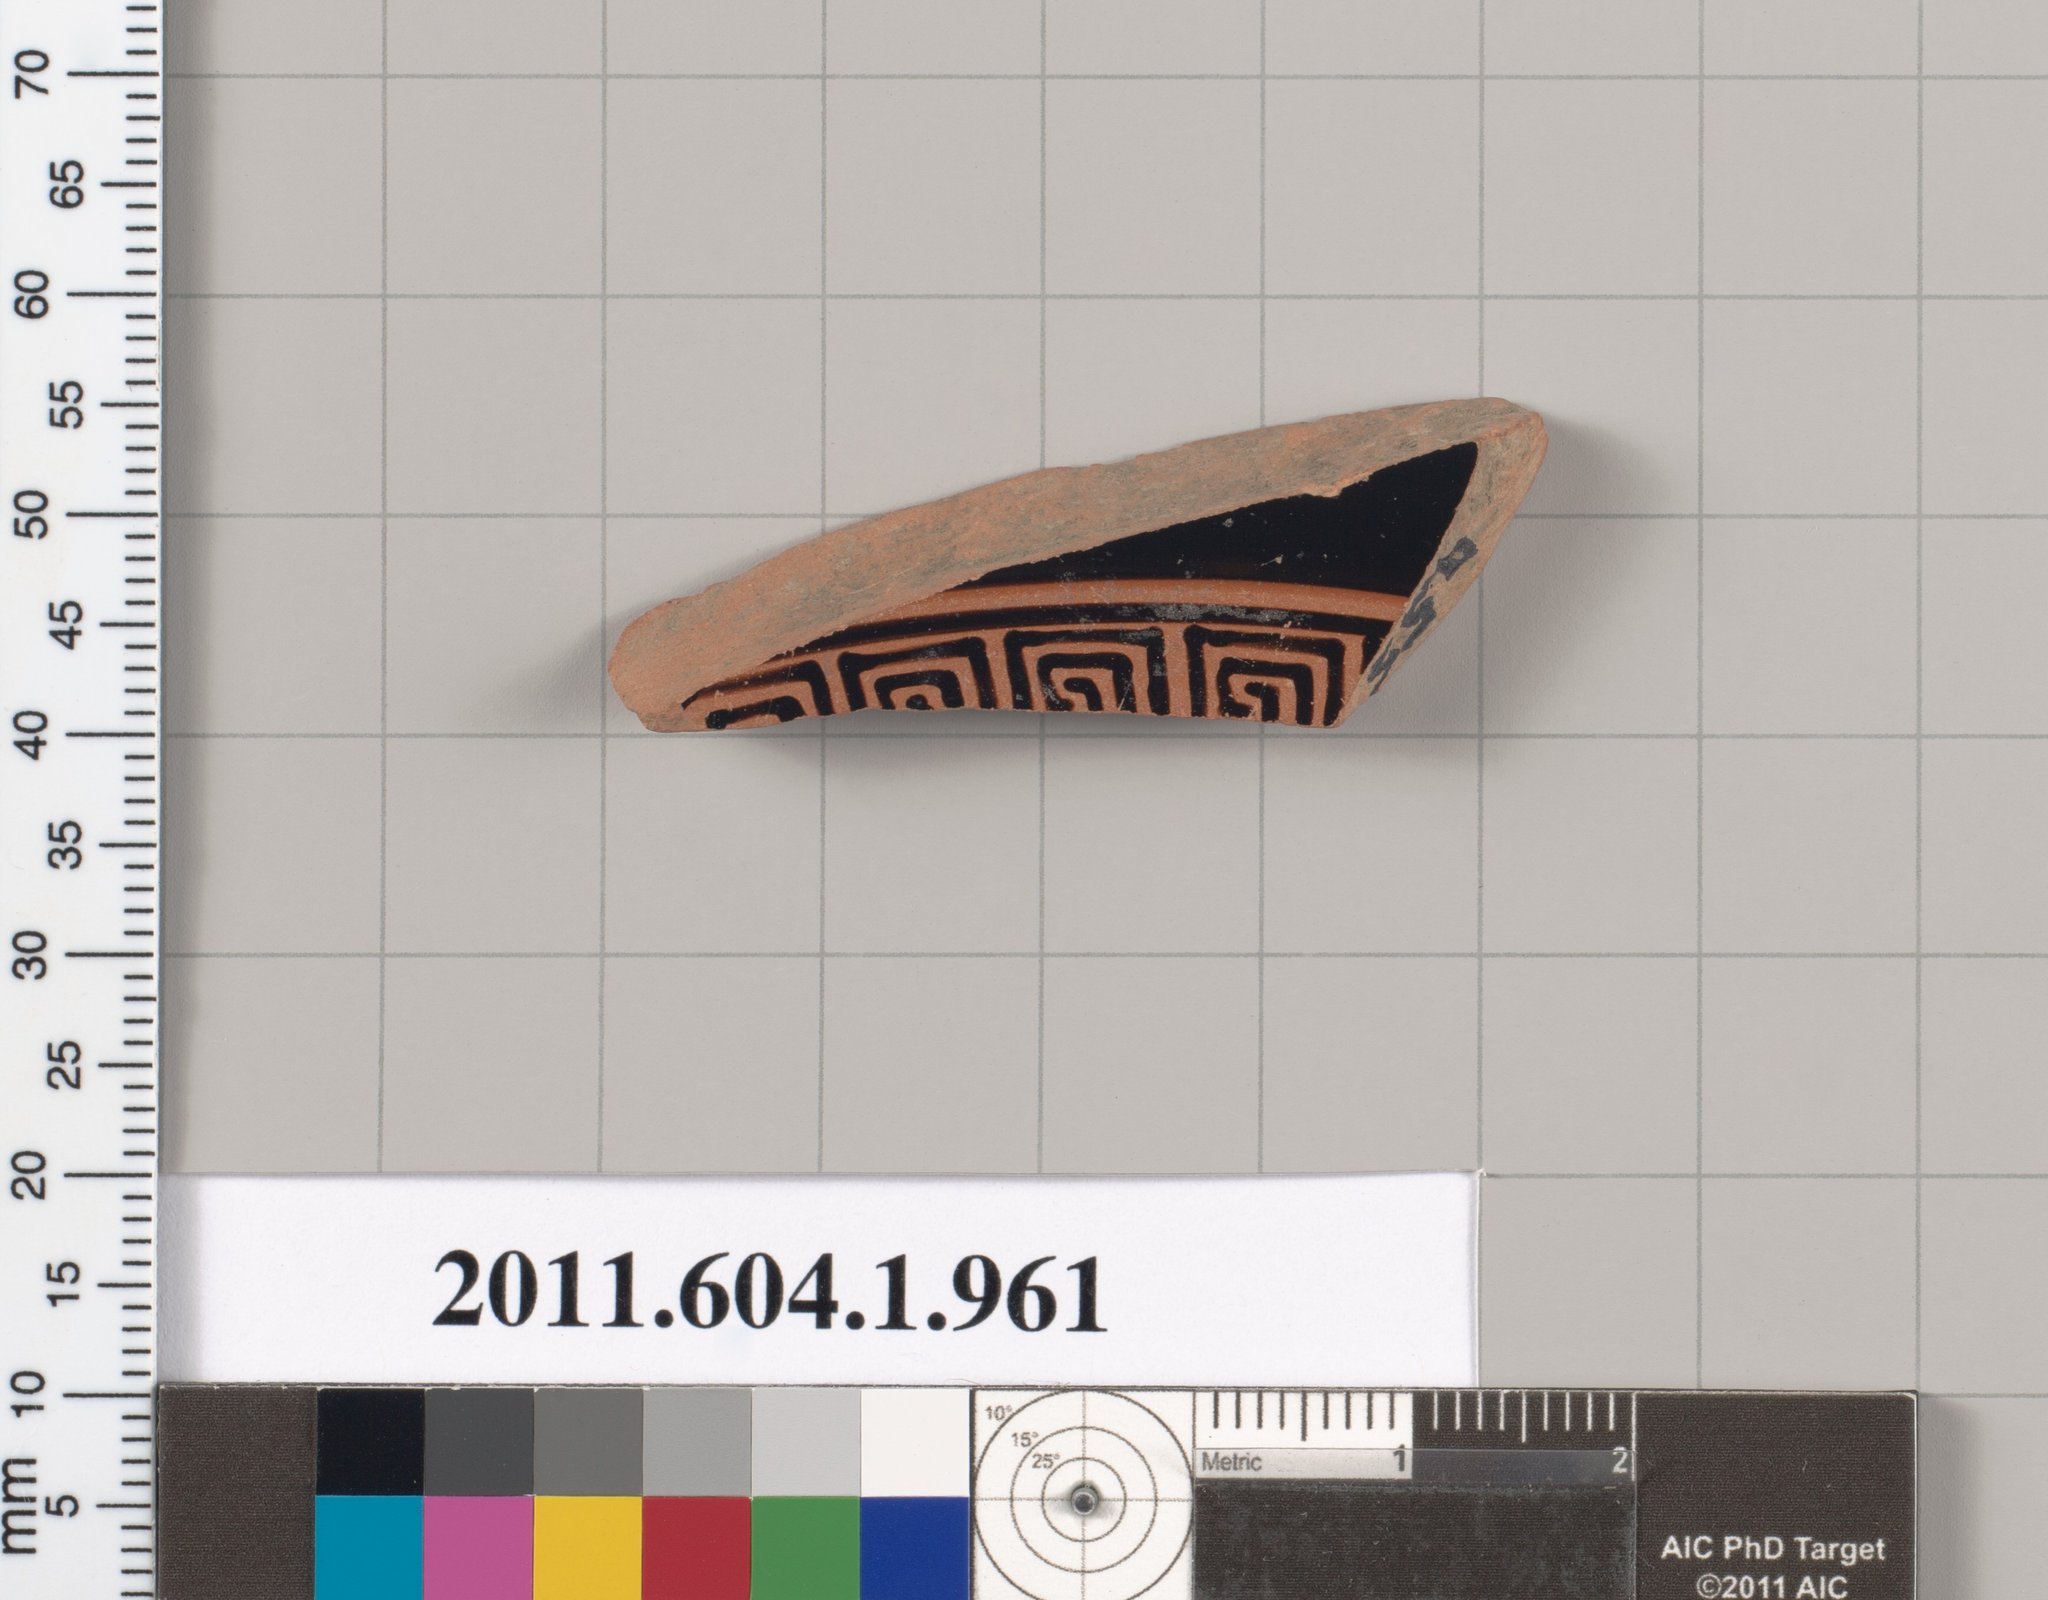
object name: kylix fragment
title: Terracotta fragment of a kylix (drinking cup)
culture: greek, attic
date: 490-480 BCE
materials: terracotta